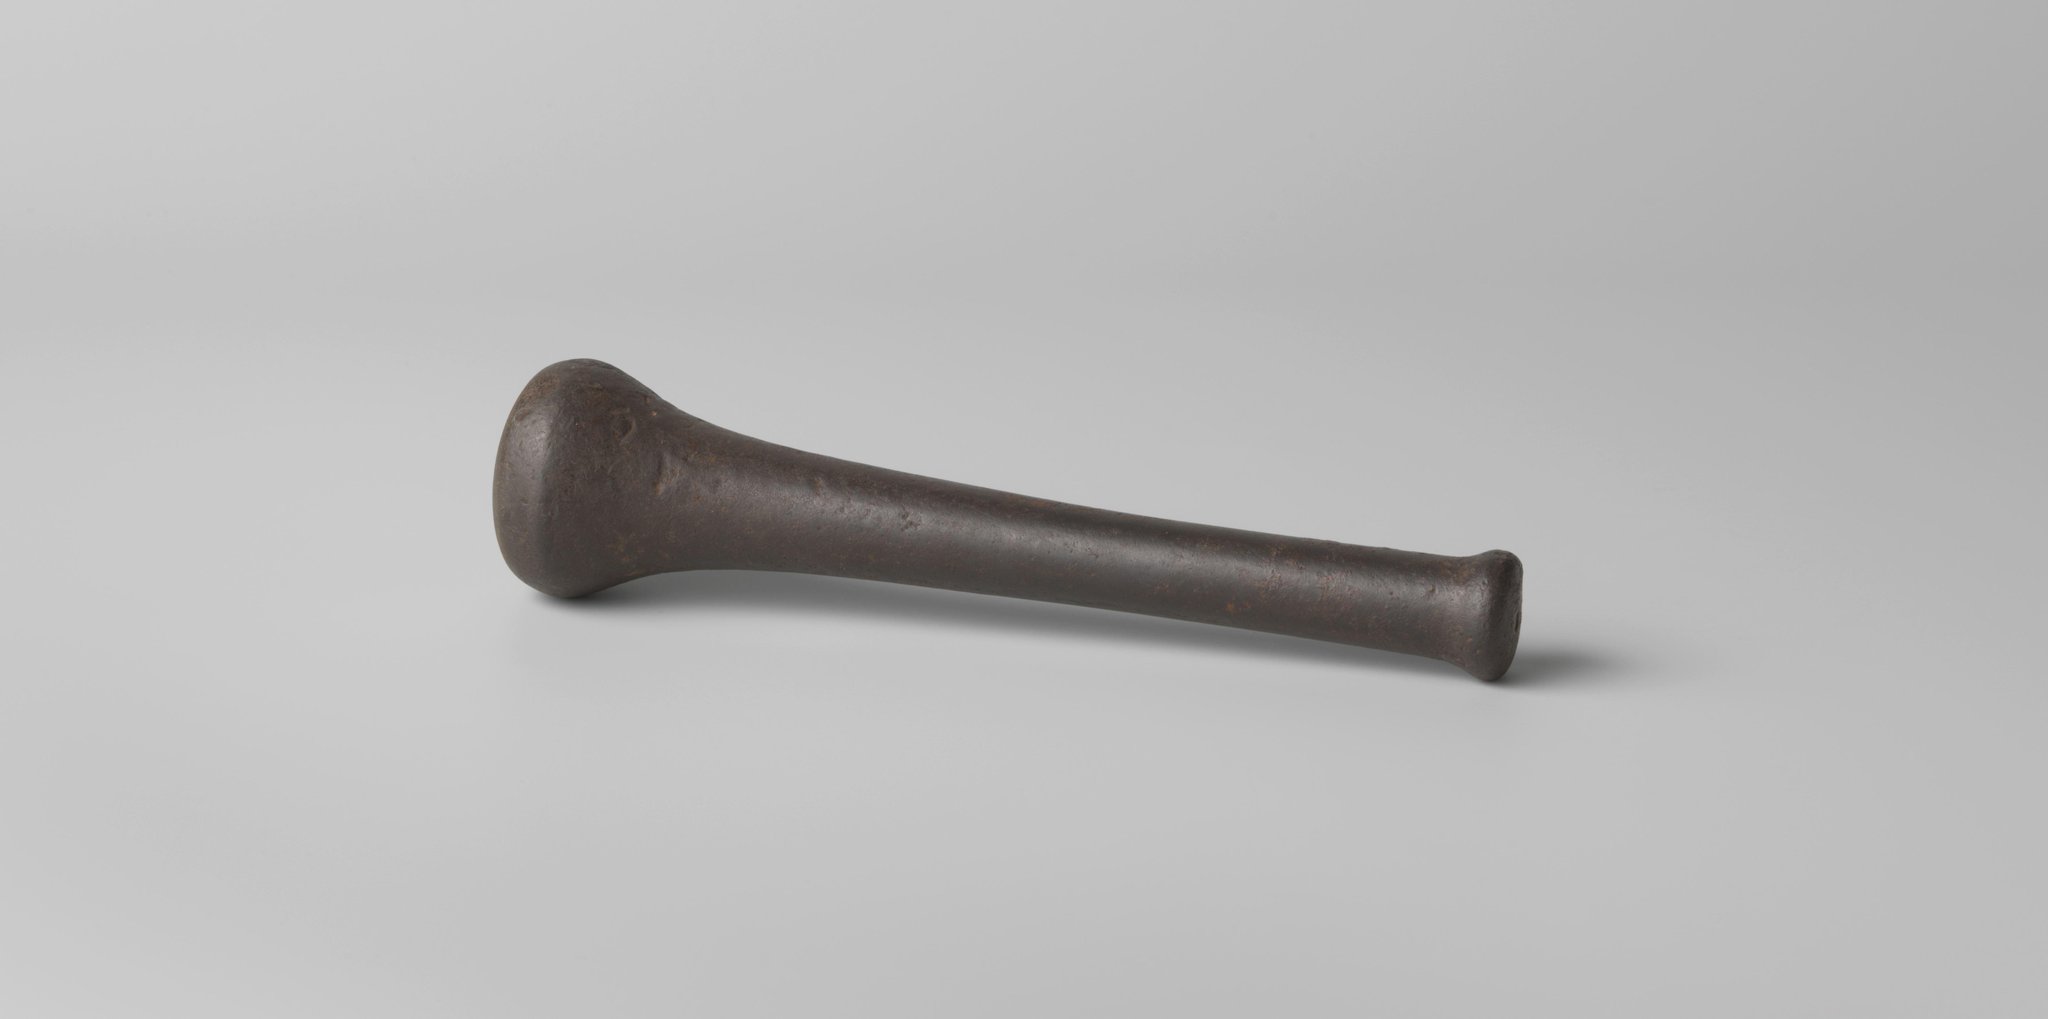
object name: beater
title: Stamper van gietijzer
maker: peeter van den ghein (ii)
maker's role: brazier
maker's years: 1525-1598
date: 1591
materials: iron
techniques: casting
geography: mechelen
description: Mortar and pestlewith inscription: PETER V ANDEN GHEIN ME FECIT MCCCCCLXXXXI. Bronze. Mechelen, 1591, Peter van den Ghein II.